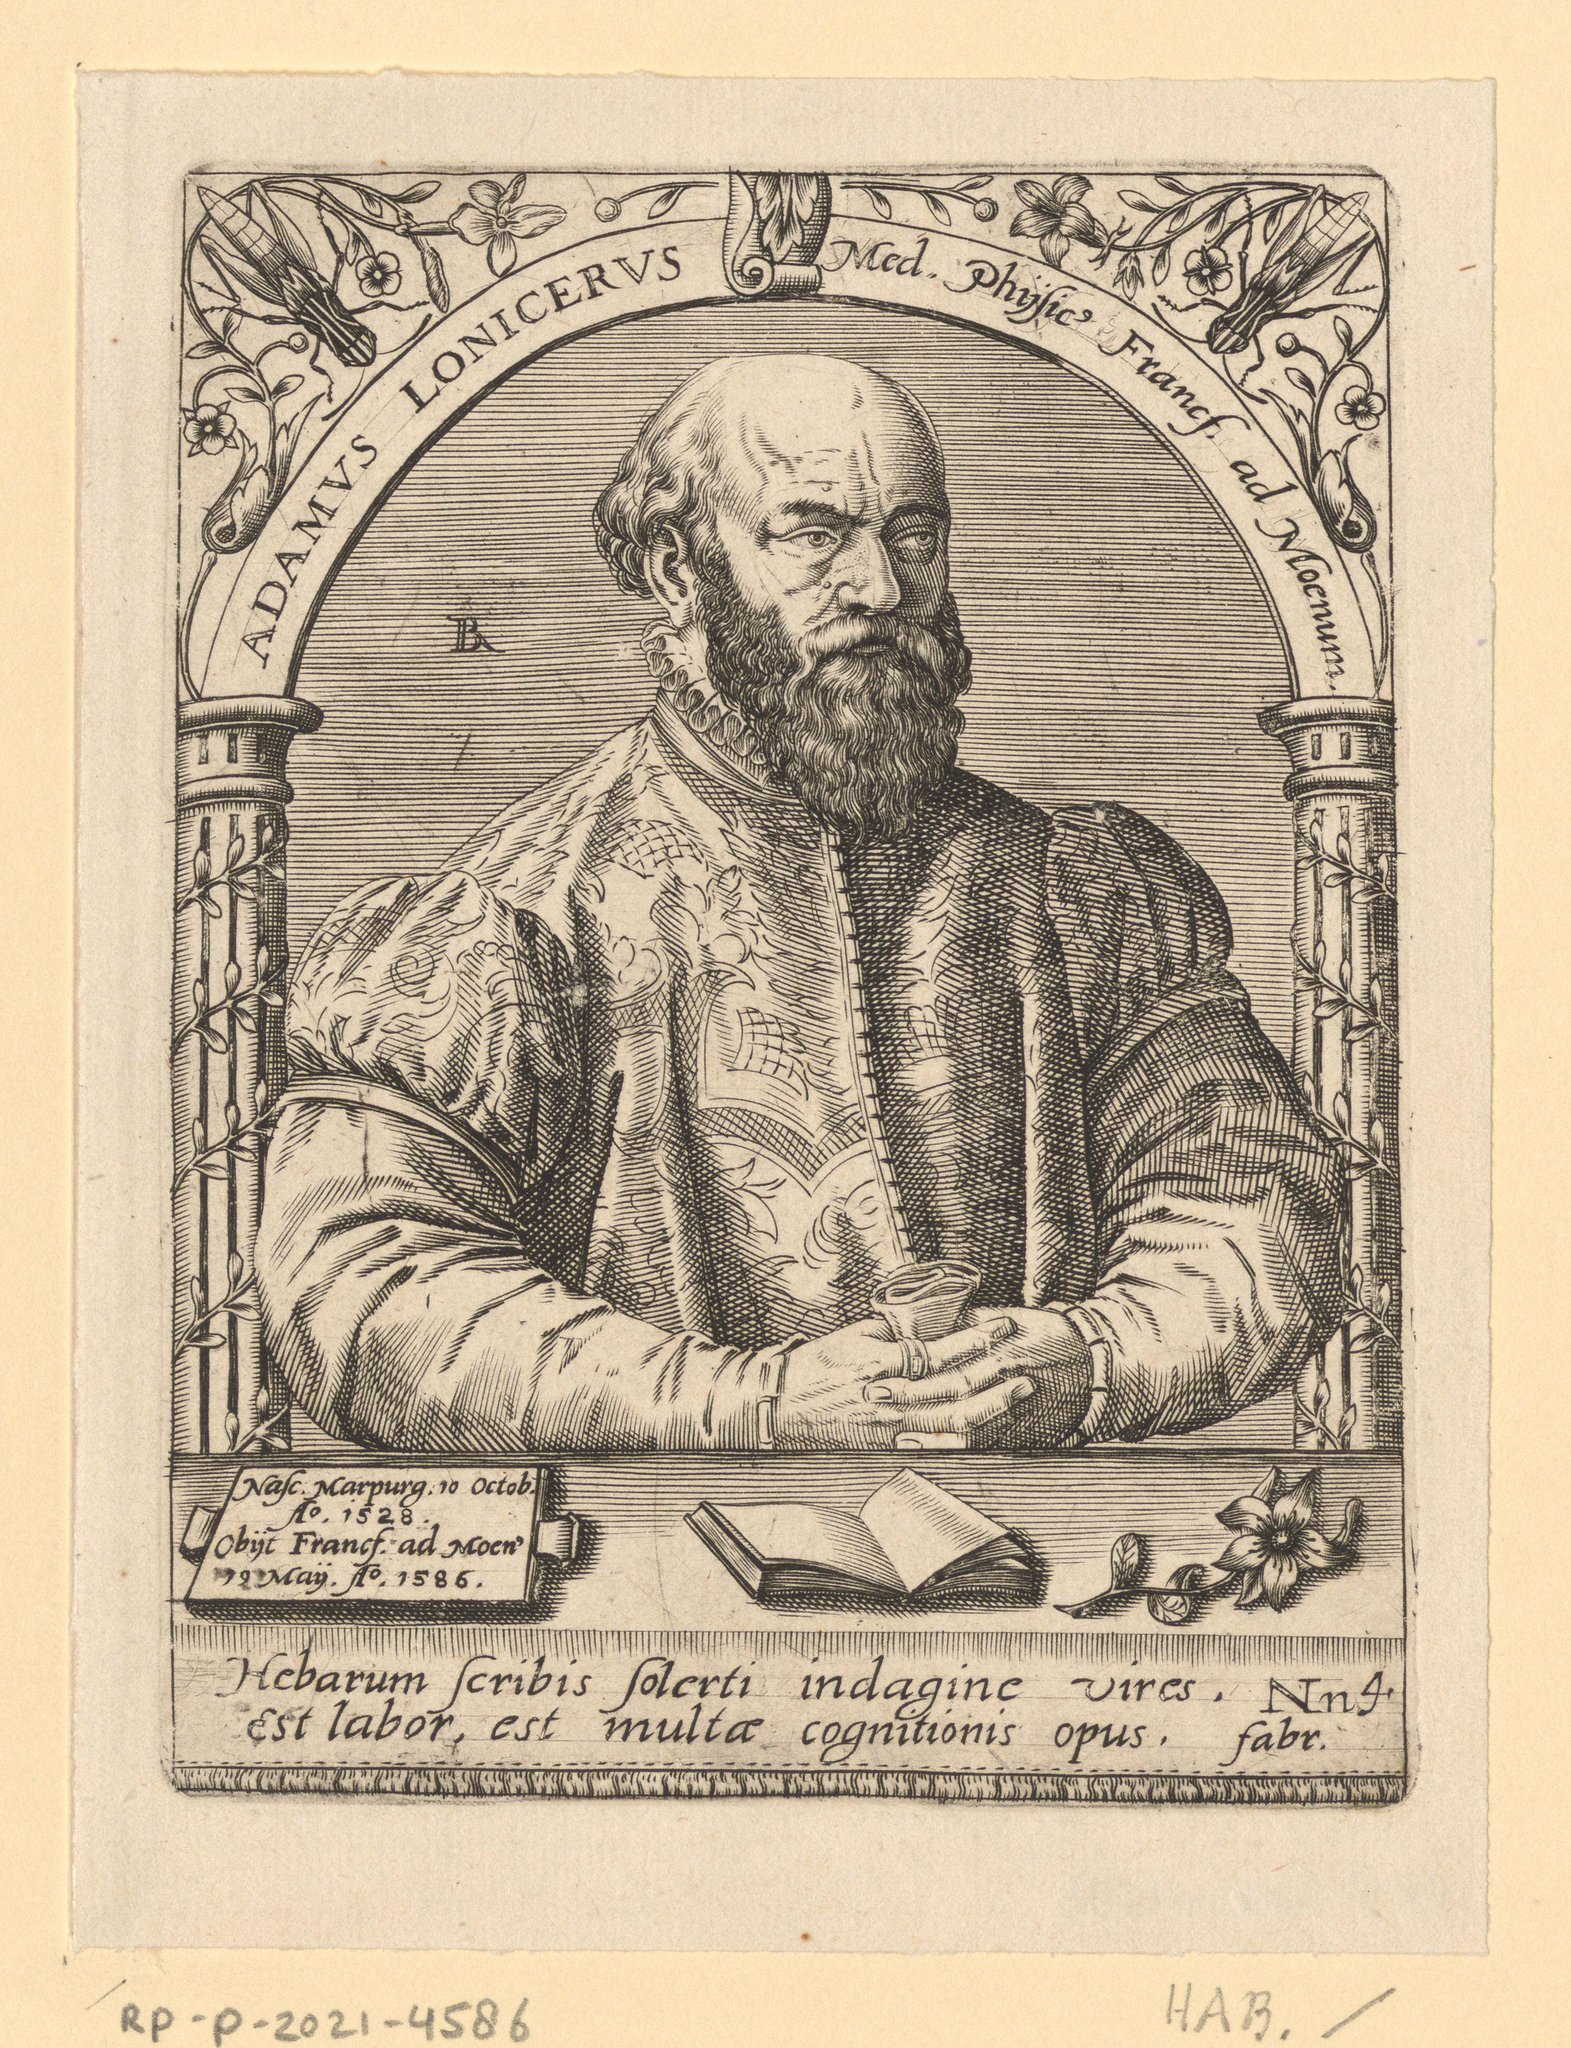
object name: print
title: Portretten van geleerden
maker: robert boissard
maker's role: print maker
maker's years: 1570-1611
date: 1650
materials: paper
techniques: engraving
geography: france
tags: physicist, fruits and vegetables ~ ornament, botany (+ portrait of scholar, scientist), historical persons, book - mm - book open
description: Prent voor het eerst (zonder nummering) verschenen in: Boissard, Jean-Jacques. Icones Virorum illustrium (...). Frankfurt: erven Theodor de Bry, 1598, dl. 3. Deze staat is gebruikt voor het eerste deel van Bibliotheca Chalcograhica (...)', 1650.